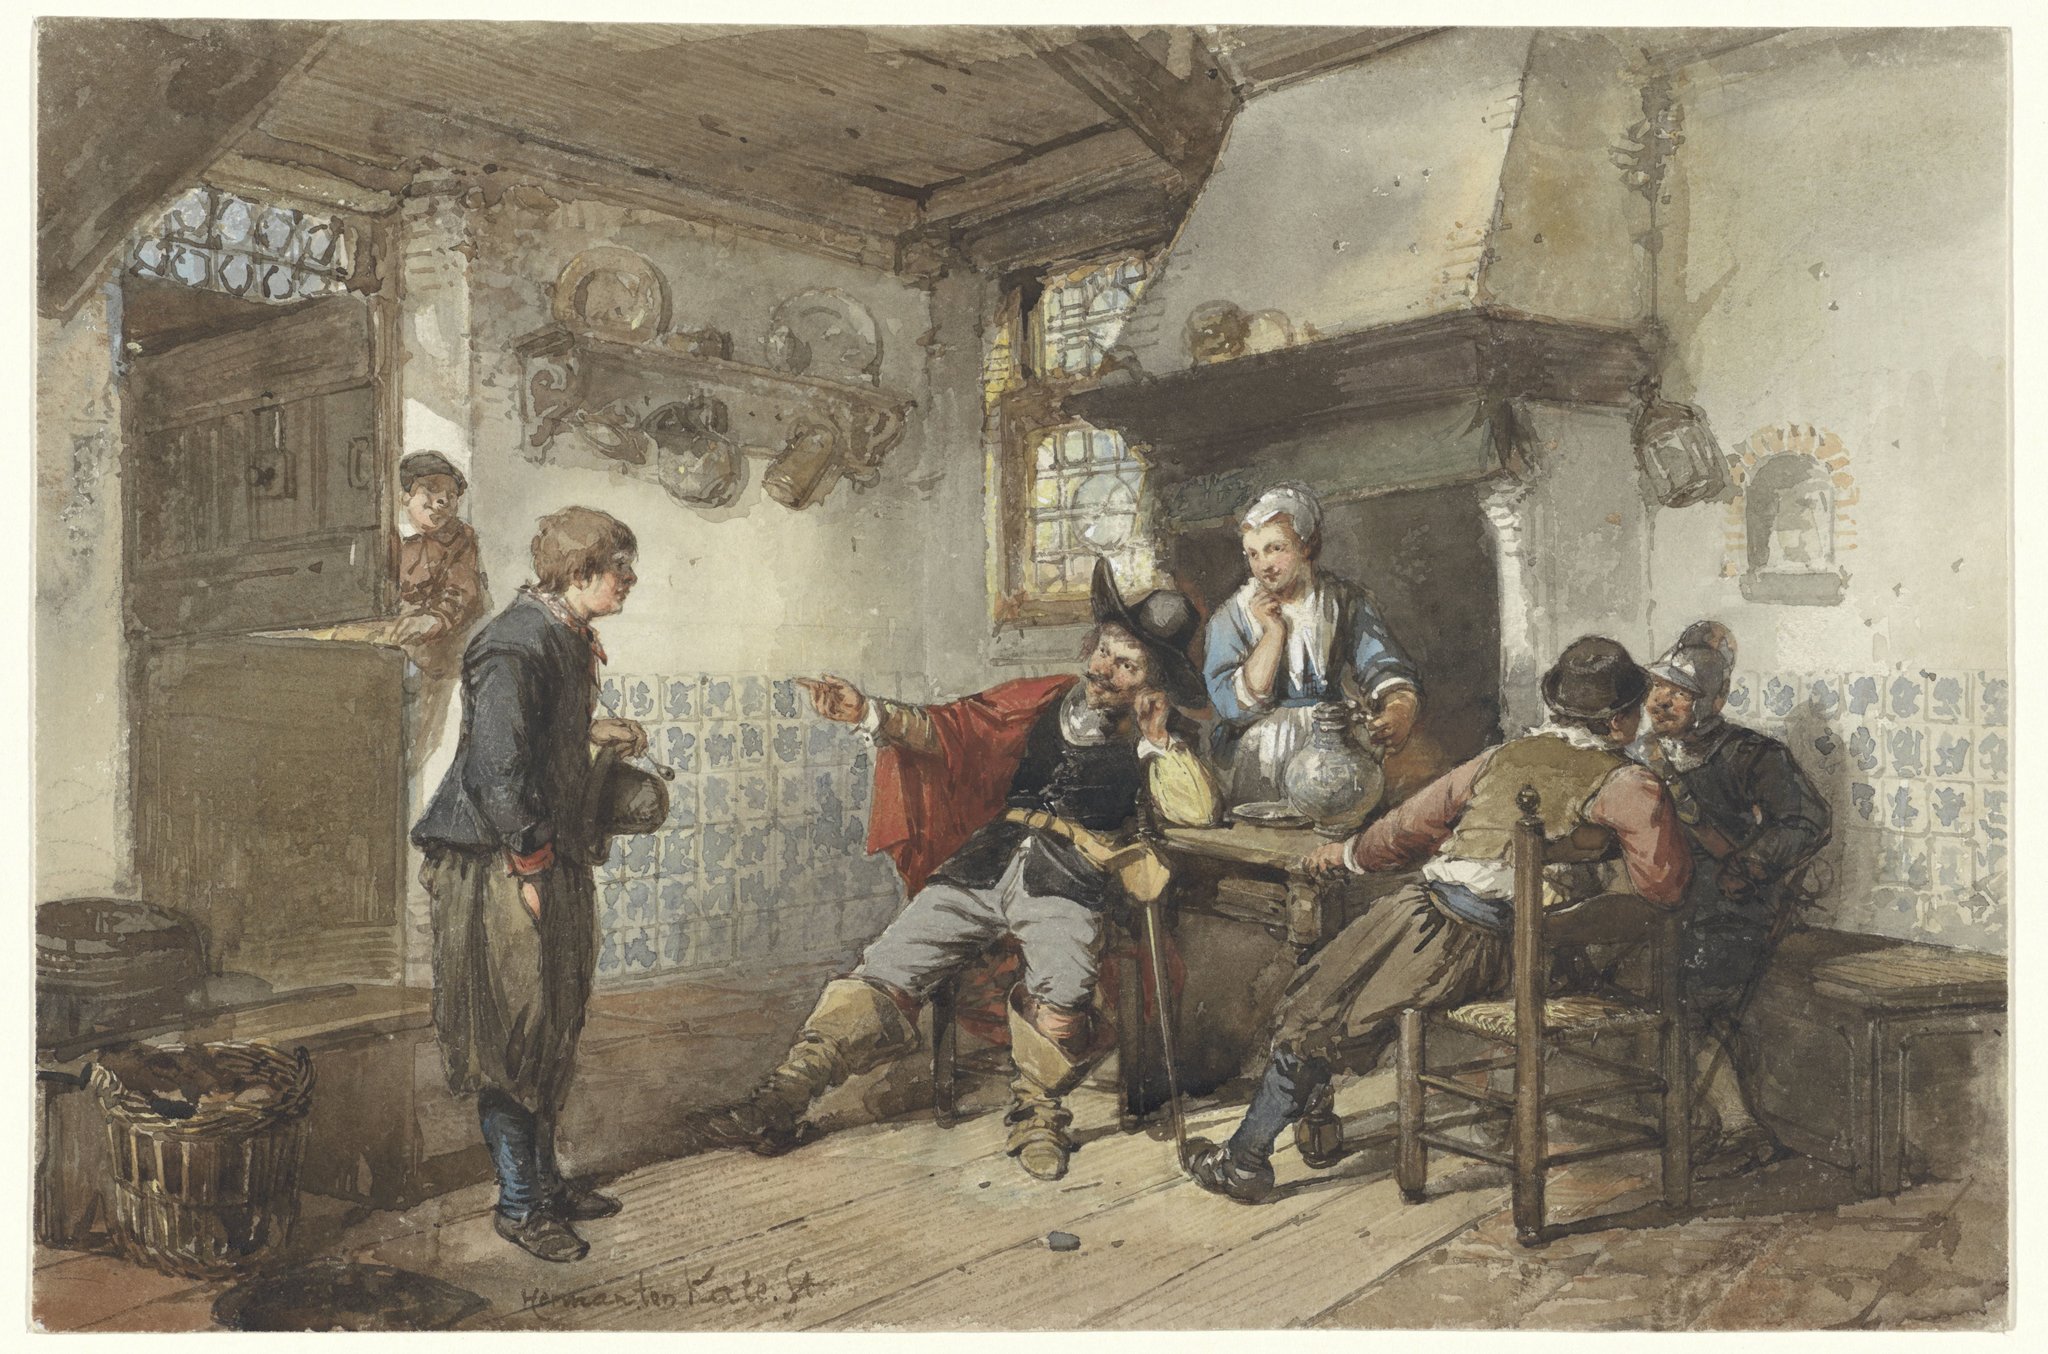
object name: drawing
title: Enkele mannen en een soldaat in een herberg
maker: herman frederik carel ten kate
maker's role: draughtsman, painter, print maker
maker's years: 1822-1891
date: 1832-1891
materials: chalk, paint, paper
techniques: brush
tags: inn, coffee-house, public house, etc.